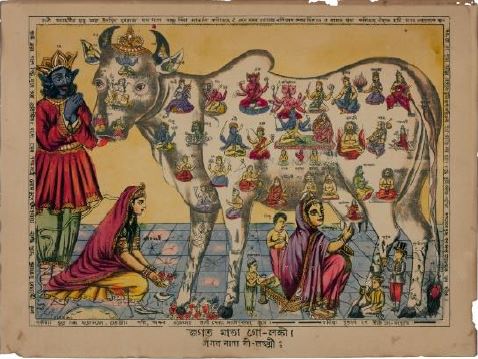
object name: print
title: Jagat Mata Go-Laxmi (World Mother Cow of Good Fortune)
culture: indian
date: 1885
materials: glaze, watercolor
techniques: hand coloring, lithograph